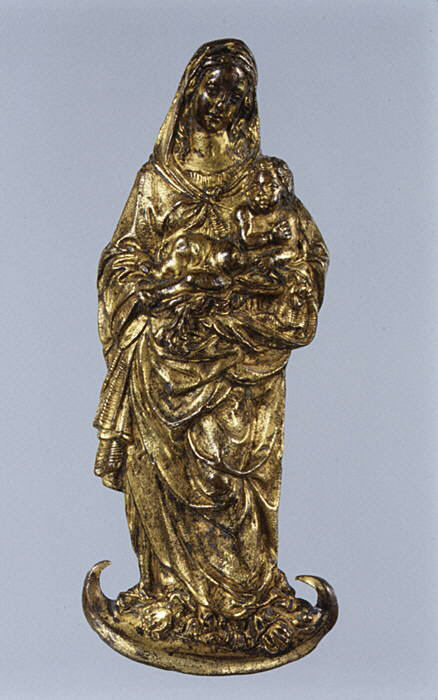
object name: plaquette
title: Virgin and Child on a crescent moon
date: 1467-1533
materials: gilt bronze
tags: moon,madonna and child